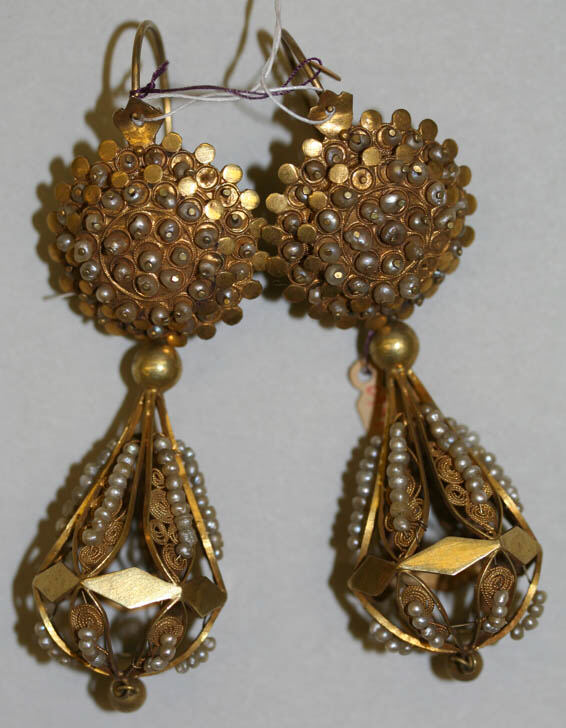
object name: earring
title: Earrings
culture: european, eastern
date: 1701-1900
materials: metal